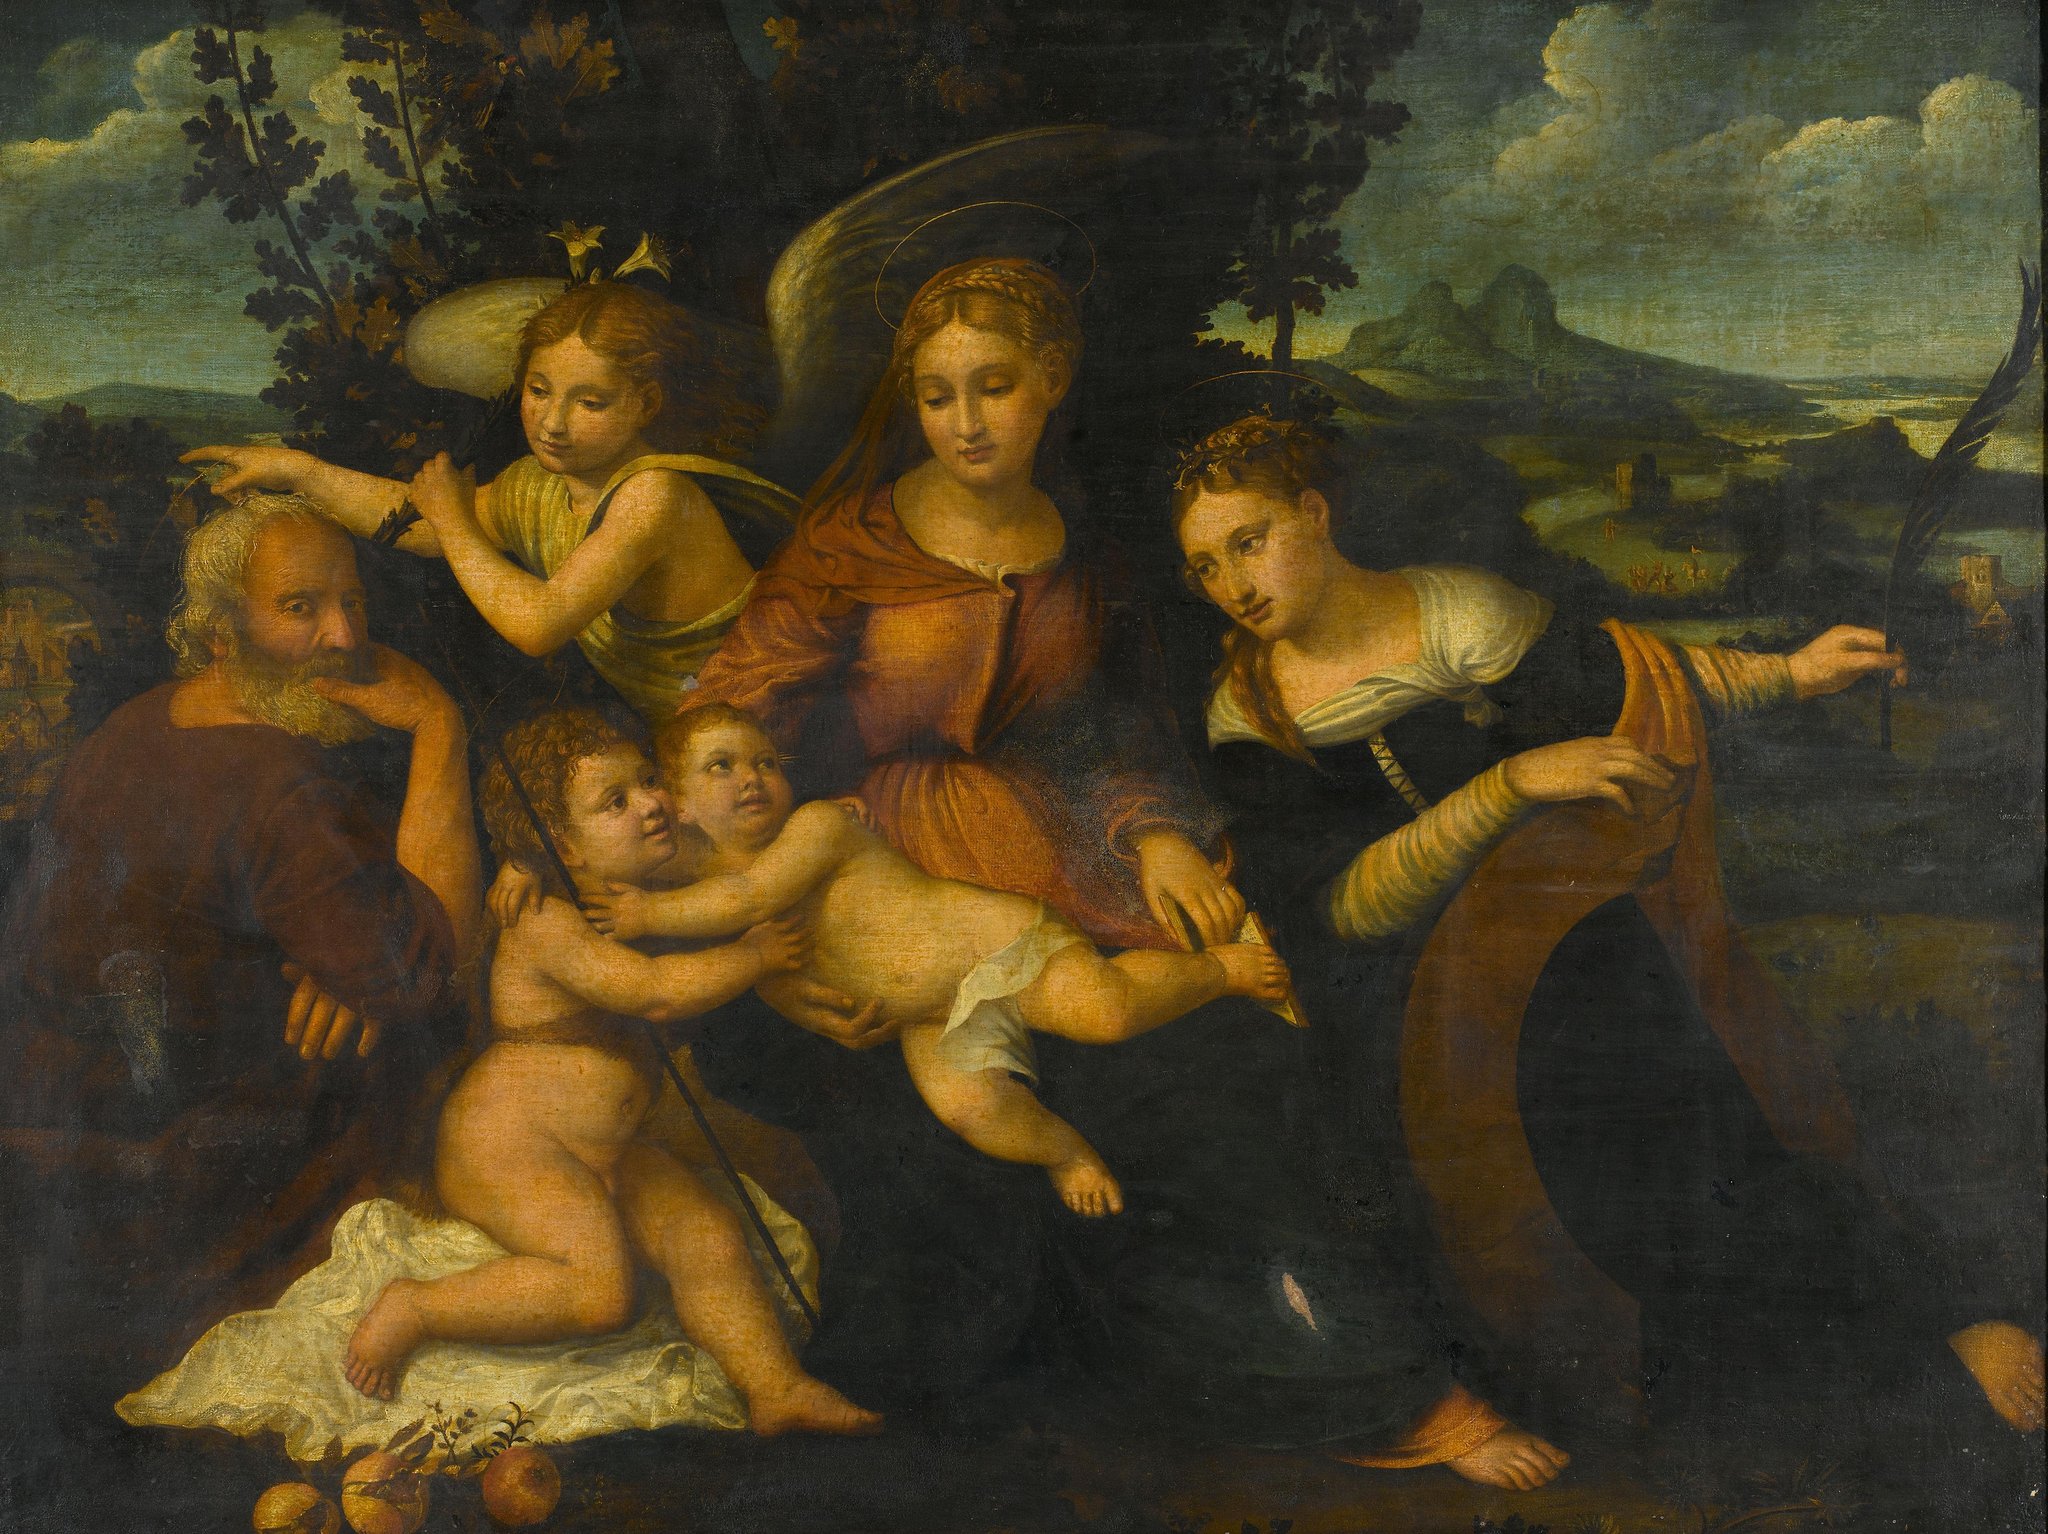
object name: painting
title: Holy Family with Saint Catherine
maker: francesco torbido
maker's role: painter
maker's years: 1482-1562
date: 1525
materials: canvas, oil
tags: the virgin martyr catherine of alexandria; possible attributes: book, crown, emperor maxentius, palm-branch, ring, sword, wheel, holy family with john the baptist (as child), holy family with others, e.g.: anna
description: De heilige familie met de heilige Catharina, zittend in een landschap. Johannes de Doper als kind omhelst het Christuskind, bij zijn voeten liggen twee granaatappels. Tussen Jozef en Maria staat een engel met een lelietak.